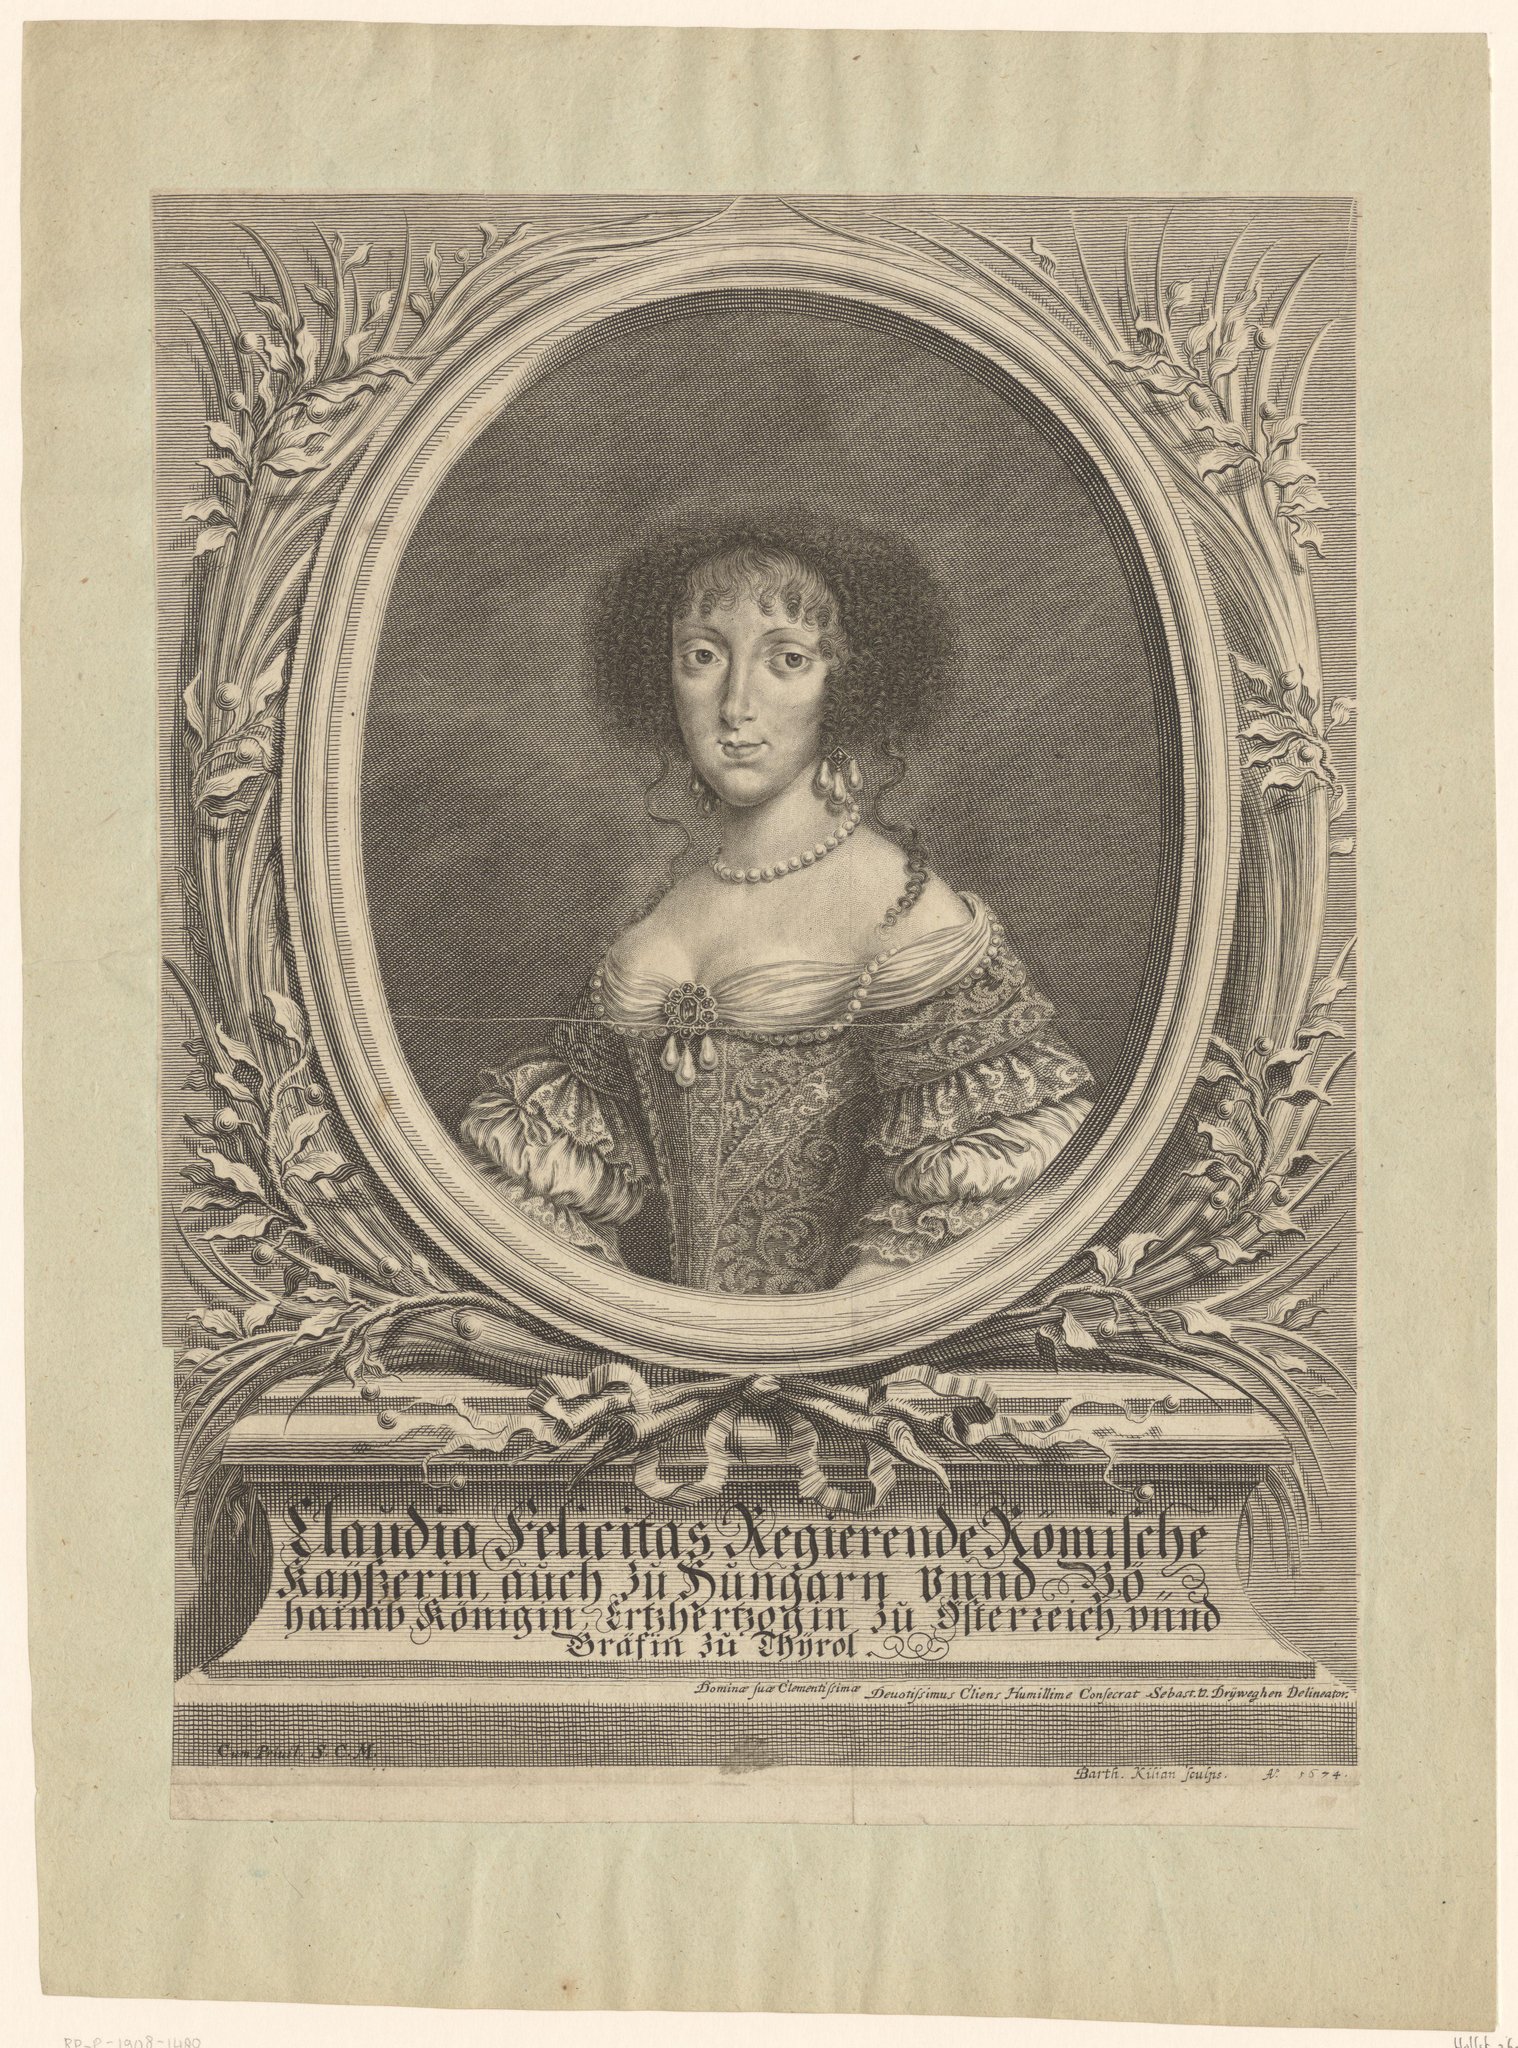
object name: print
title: Portret van Claudia Felicitas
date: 1674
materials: paper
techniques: engraving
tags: vienna, historical persons, ruler, sovereign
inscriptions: collector's mark: Lugt 2228